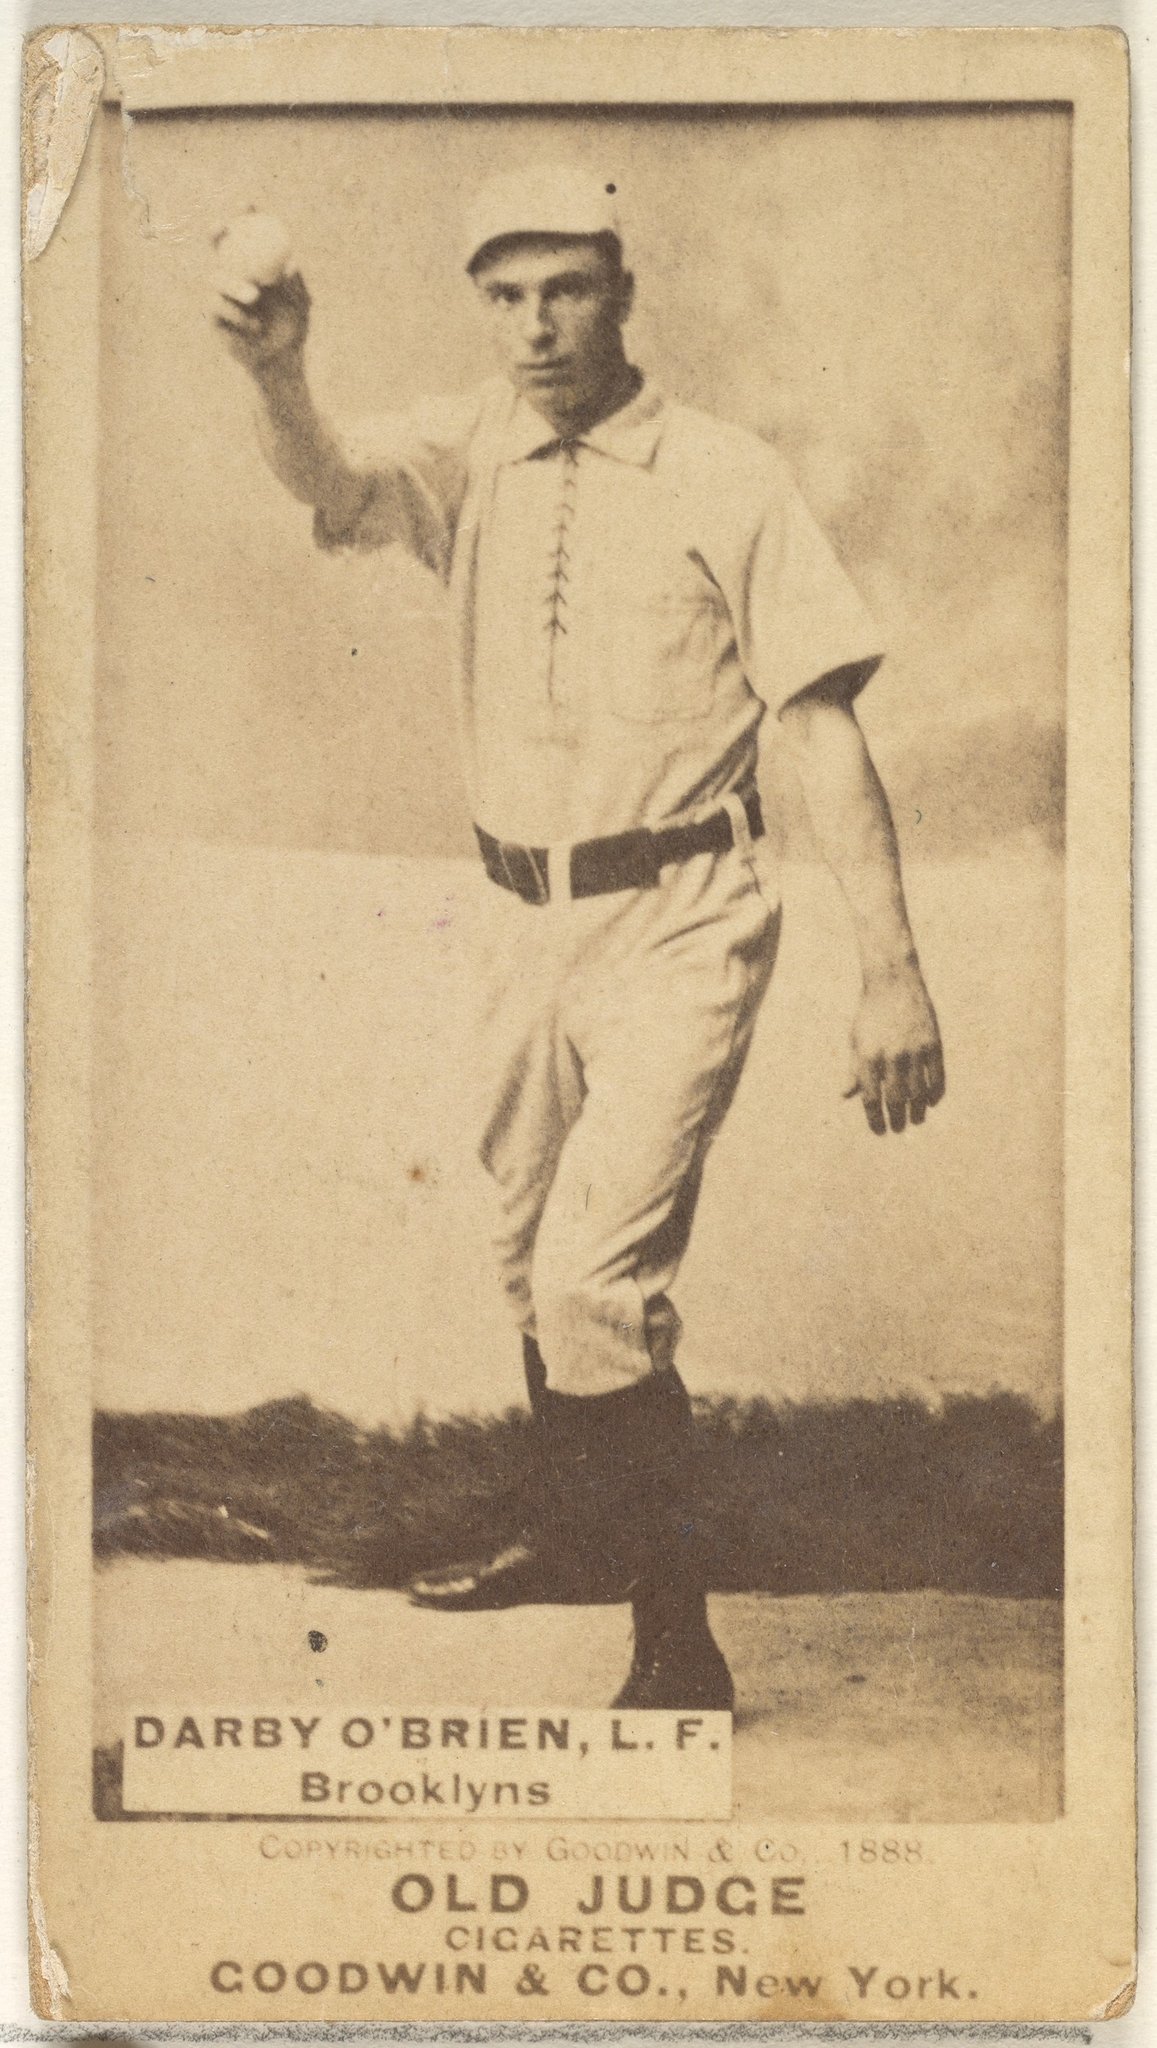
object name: baseball card, photograph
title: Darby O'Brien, Left Field, Brooklyn Bridegrooms, from the Old Judge series (N172) for Old Judge Cigarettes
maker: goodwin & company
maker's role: publisher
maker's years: 1850-1950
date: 1888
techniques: albumen silver print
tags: men,portraits,baseball,athletes